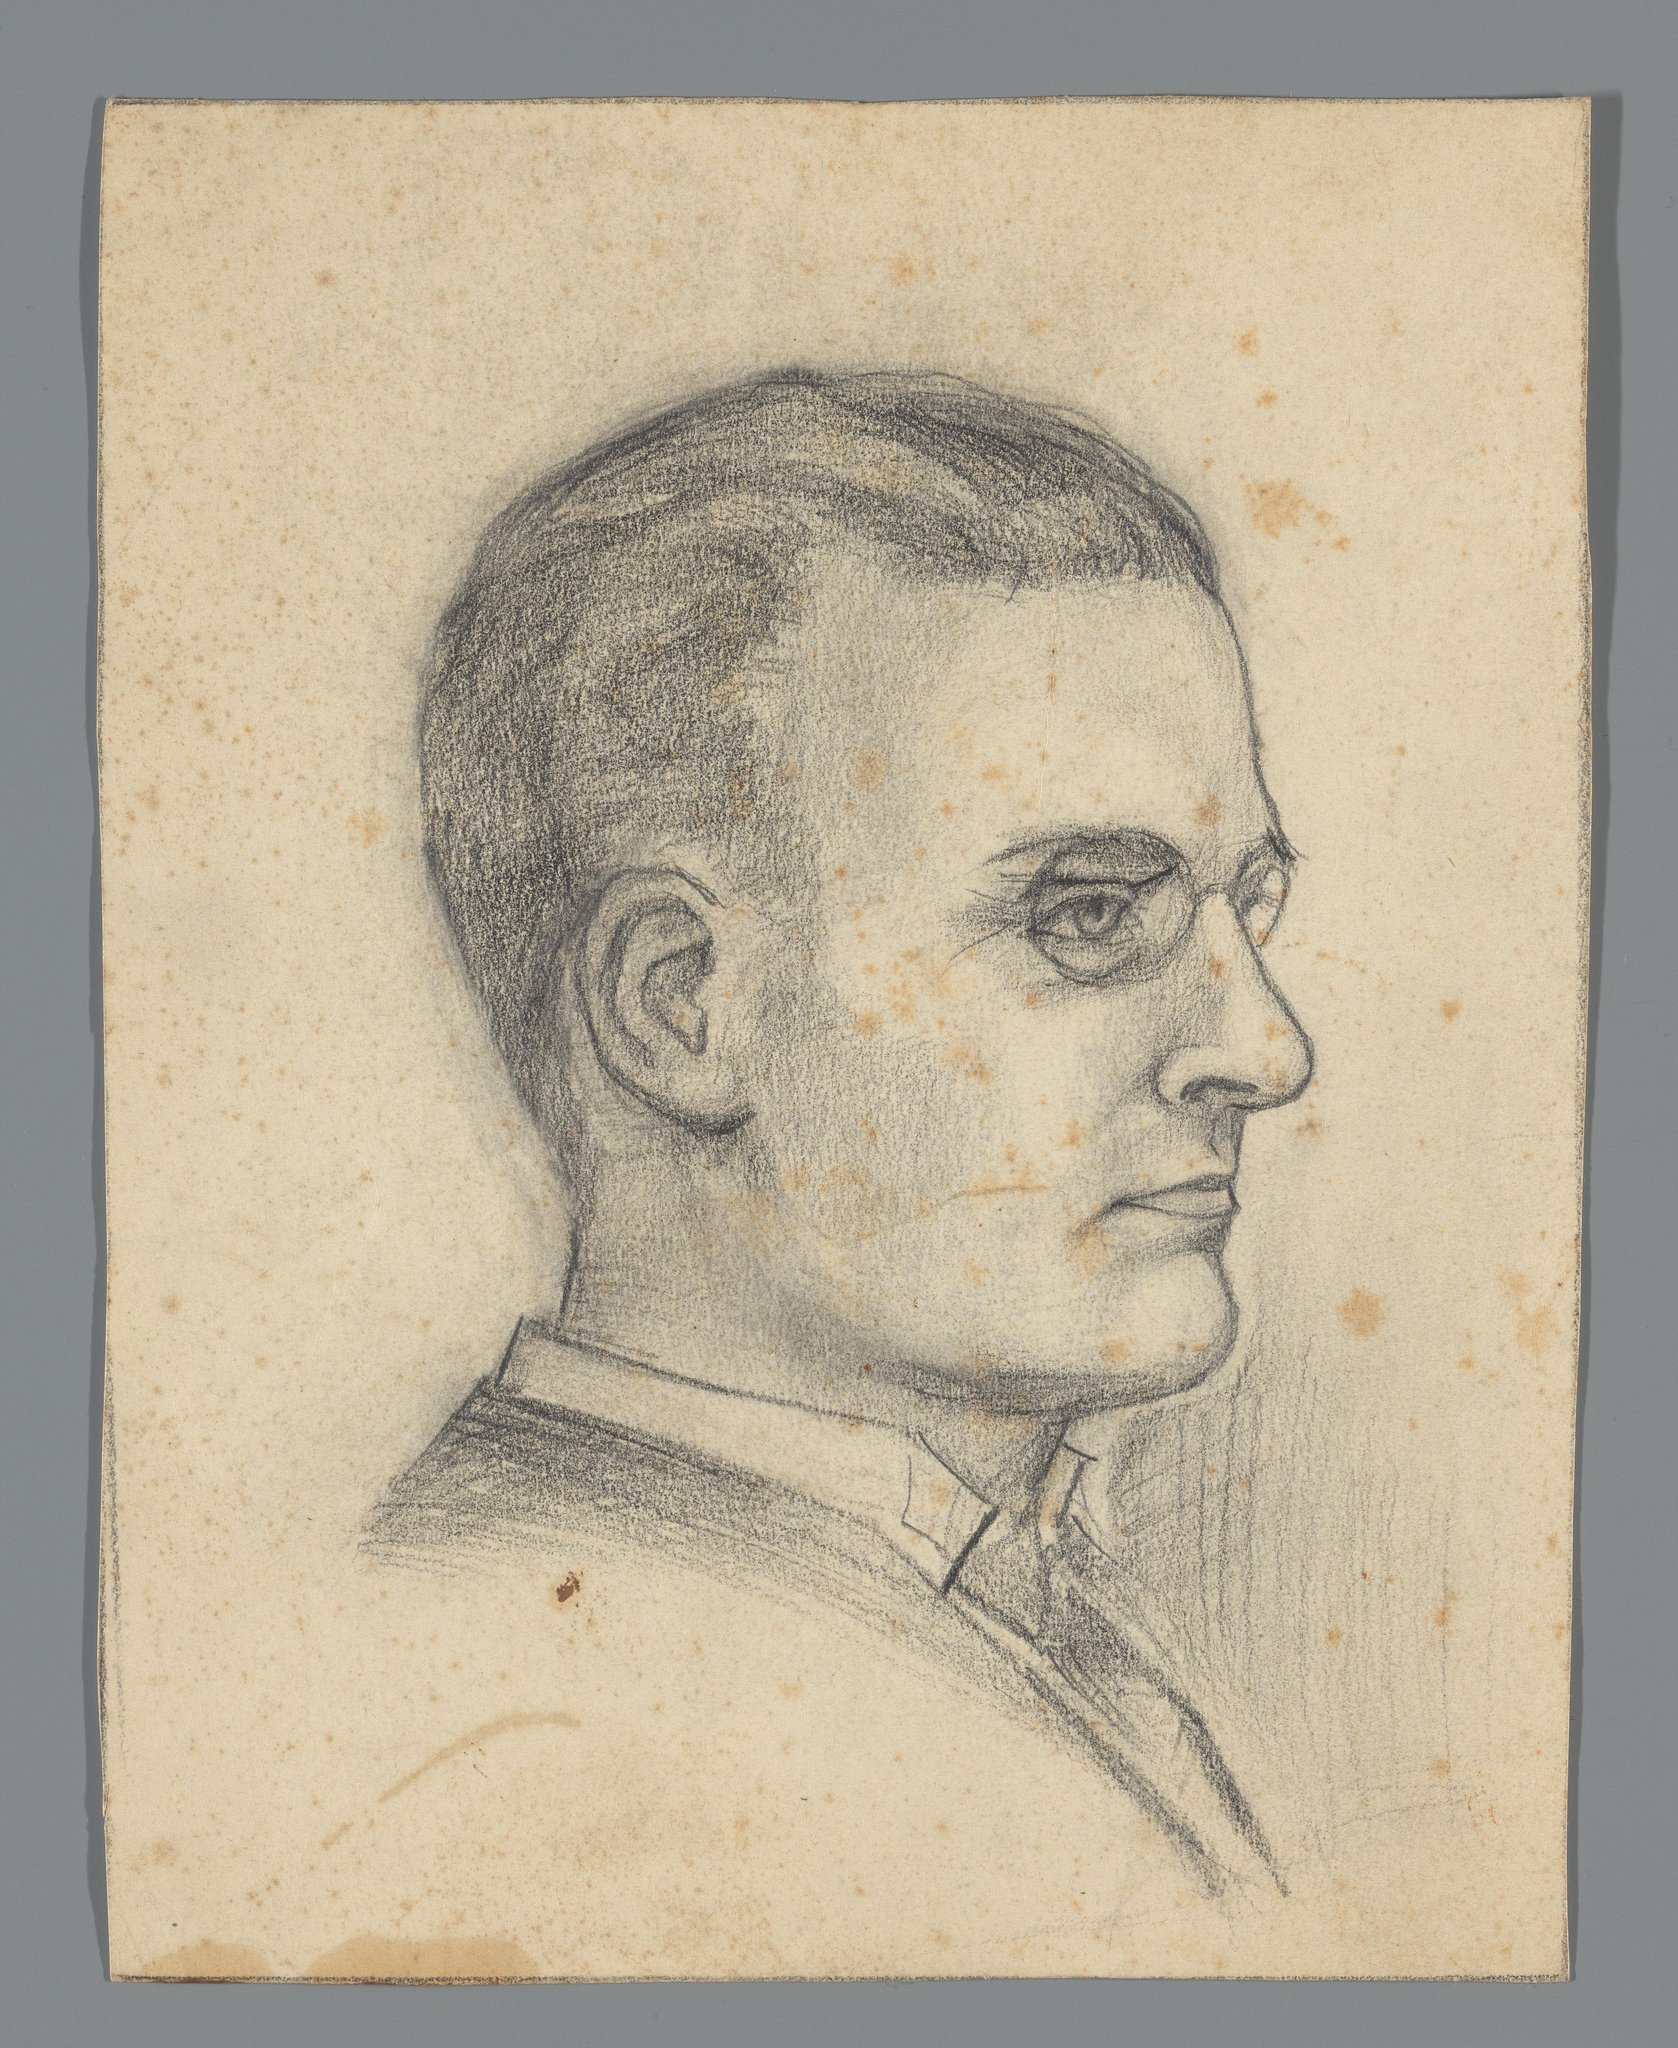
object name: drawing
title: Portret van R.J. Boers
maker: Anonymous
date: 1894-1919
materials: paper, pencil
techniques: drawing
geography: bangka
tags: robert julius boers, director, boss (in modern industry), historical persons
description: Portret van Robert Julius Boers op jonge leeftijd. Borststuk met hoofd naar rechts gewend. Hij draagt een kleine ovale bril, het haar achterover. Donkere kleding met daarboven witte boord met gevouwen punten. Potloodlijn langs buitenrand. De vier zijden van de tekening zijn niet recht; waarschijnlijk uitgeknipt. Onderdeel van een groep van losse foto's en tekeningen behorend bij het fotoalbum aangeboden aan Robert Julius Boers bij zijn vertrek naar Nederland in 1919 door het personeel van de Banka-tinwinning.